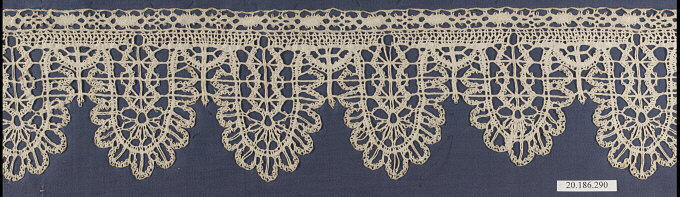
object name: edging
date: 1601-1700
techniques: lace